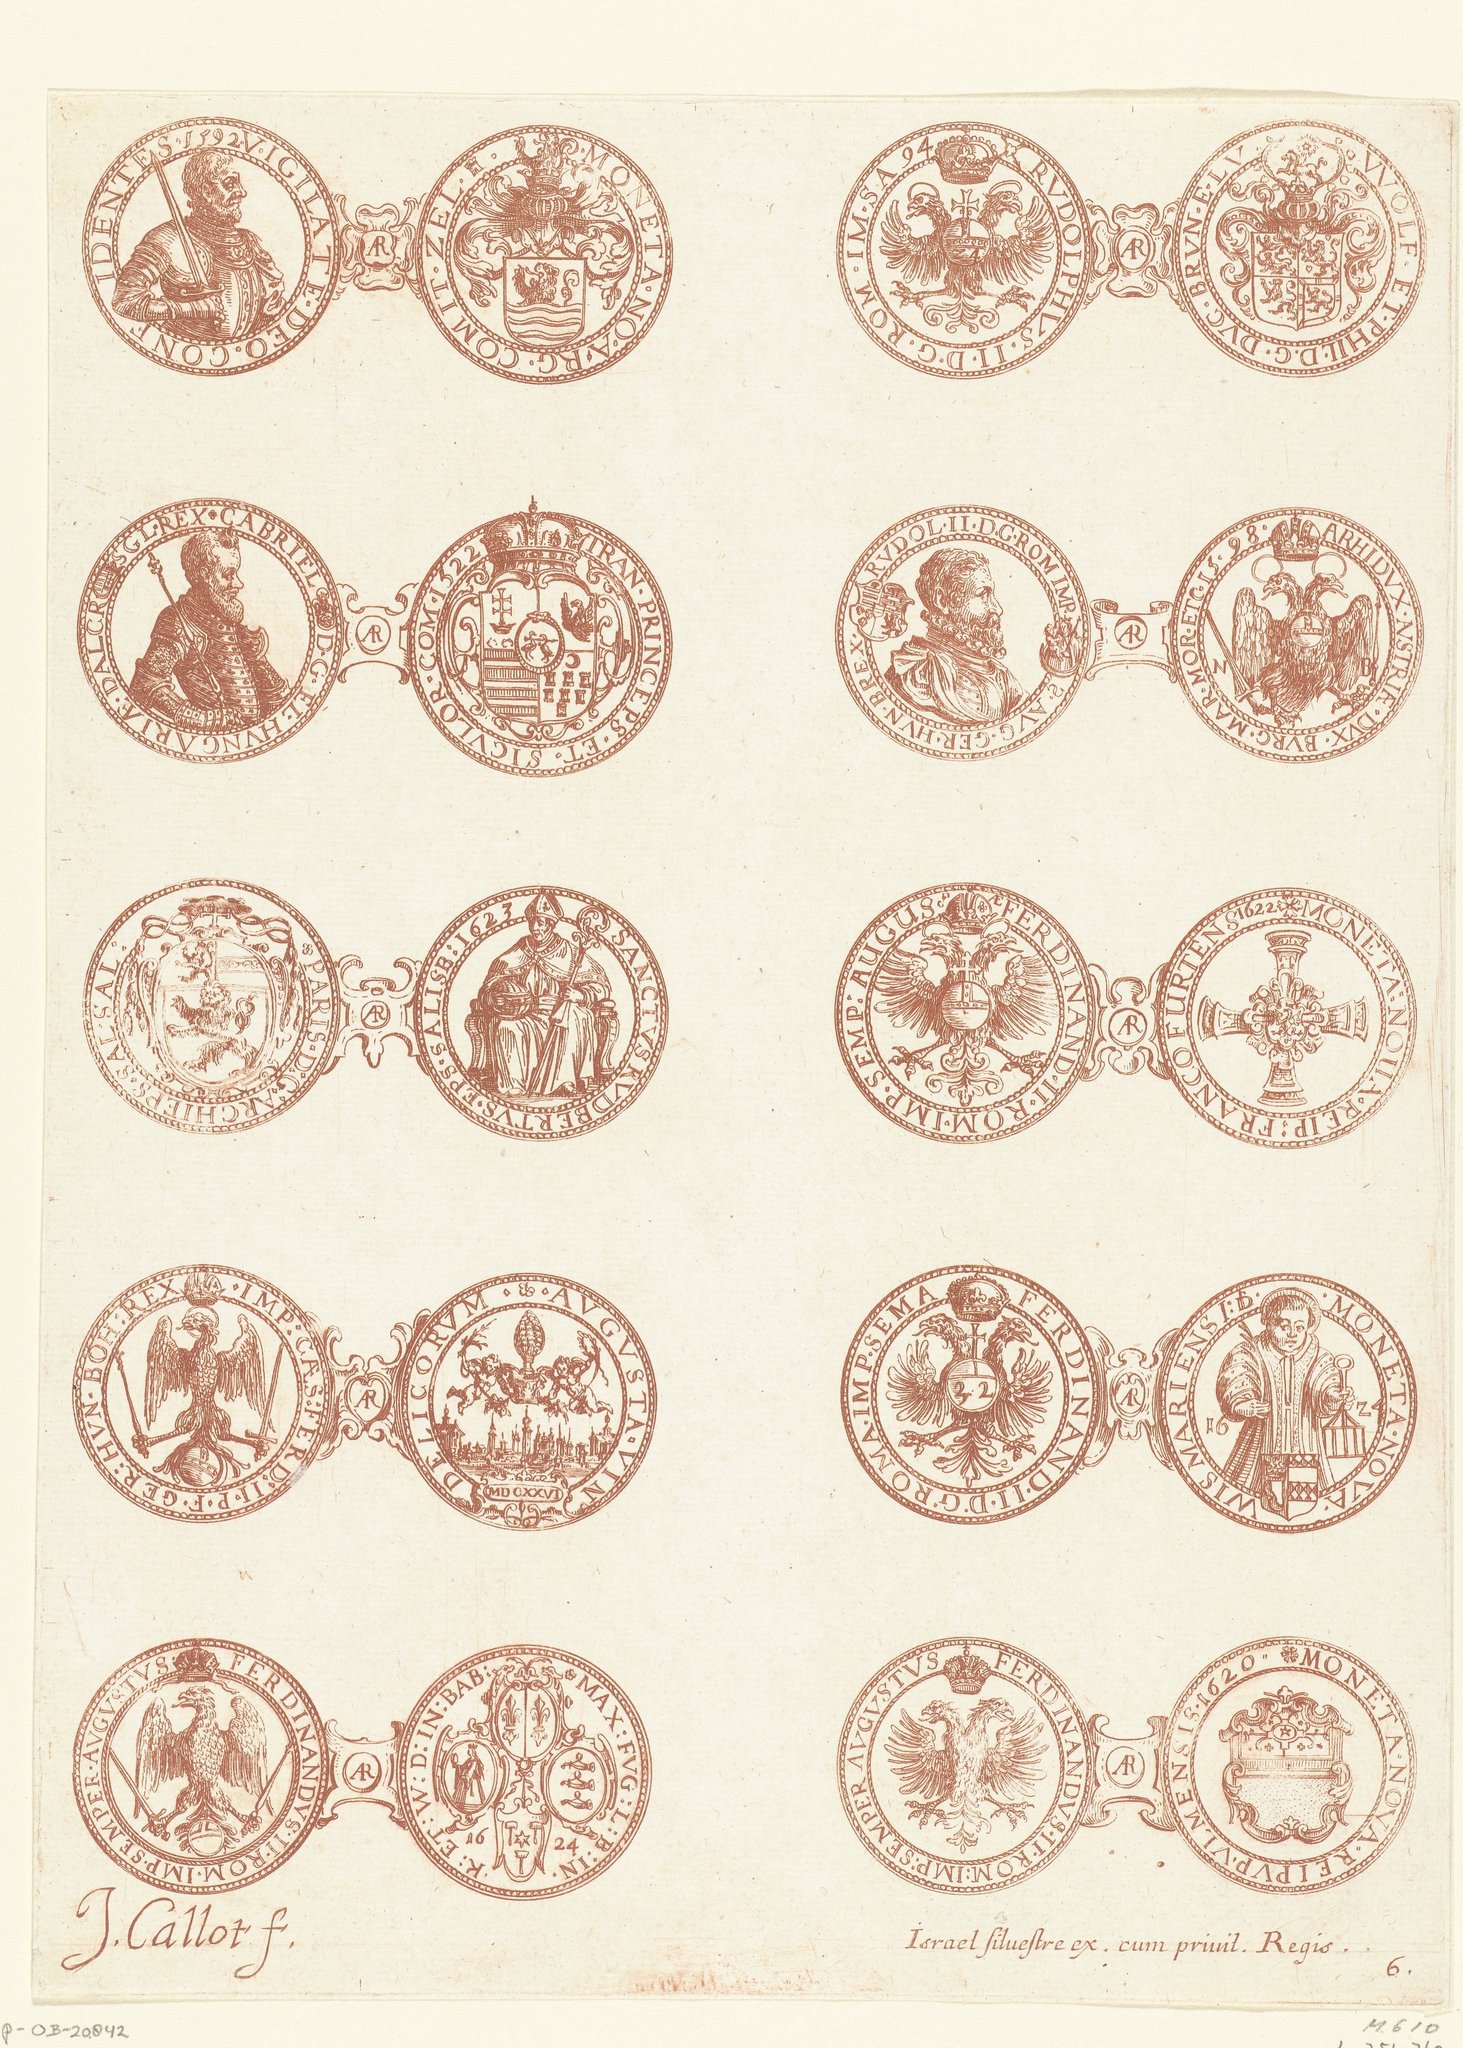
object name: print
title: Tien Europese munten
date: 1629-1630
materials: paper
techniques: etching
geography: nancy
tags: coin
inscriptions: collector's mark: Lugt 240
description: Tien Europese munten, in twee kolommen van vijf afgebeeld. Deze prent is onderdeel van een serie van tien prenten met voorstellingen van munten die tussen 1522 en 1629 in omloop gebracht zijn in Europa, voornamelijk in Duitsland en Italië. Van elke munt zijn de voor- en achterzijde naast elkaar weergegeven, verbonden door een cartouche met de letters AR (argentum - zilver) of AV (aureum - goud). De zilveren munten beslaan de eerste negen bladen en een deel van het tiende blad, dat verder voornamelijk gouden munten toont.